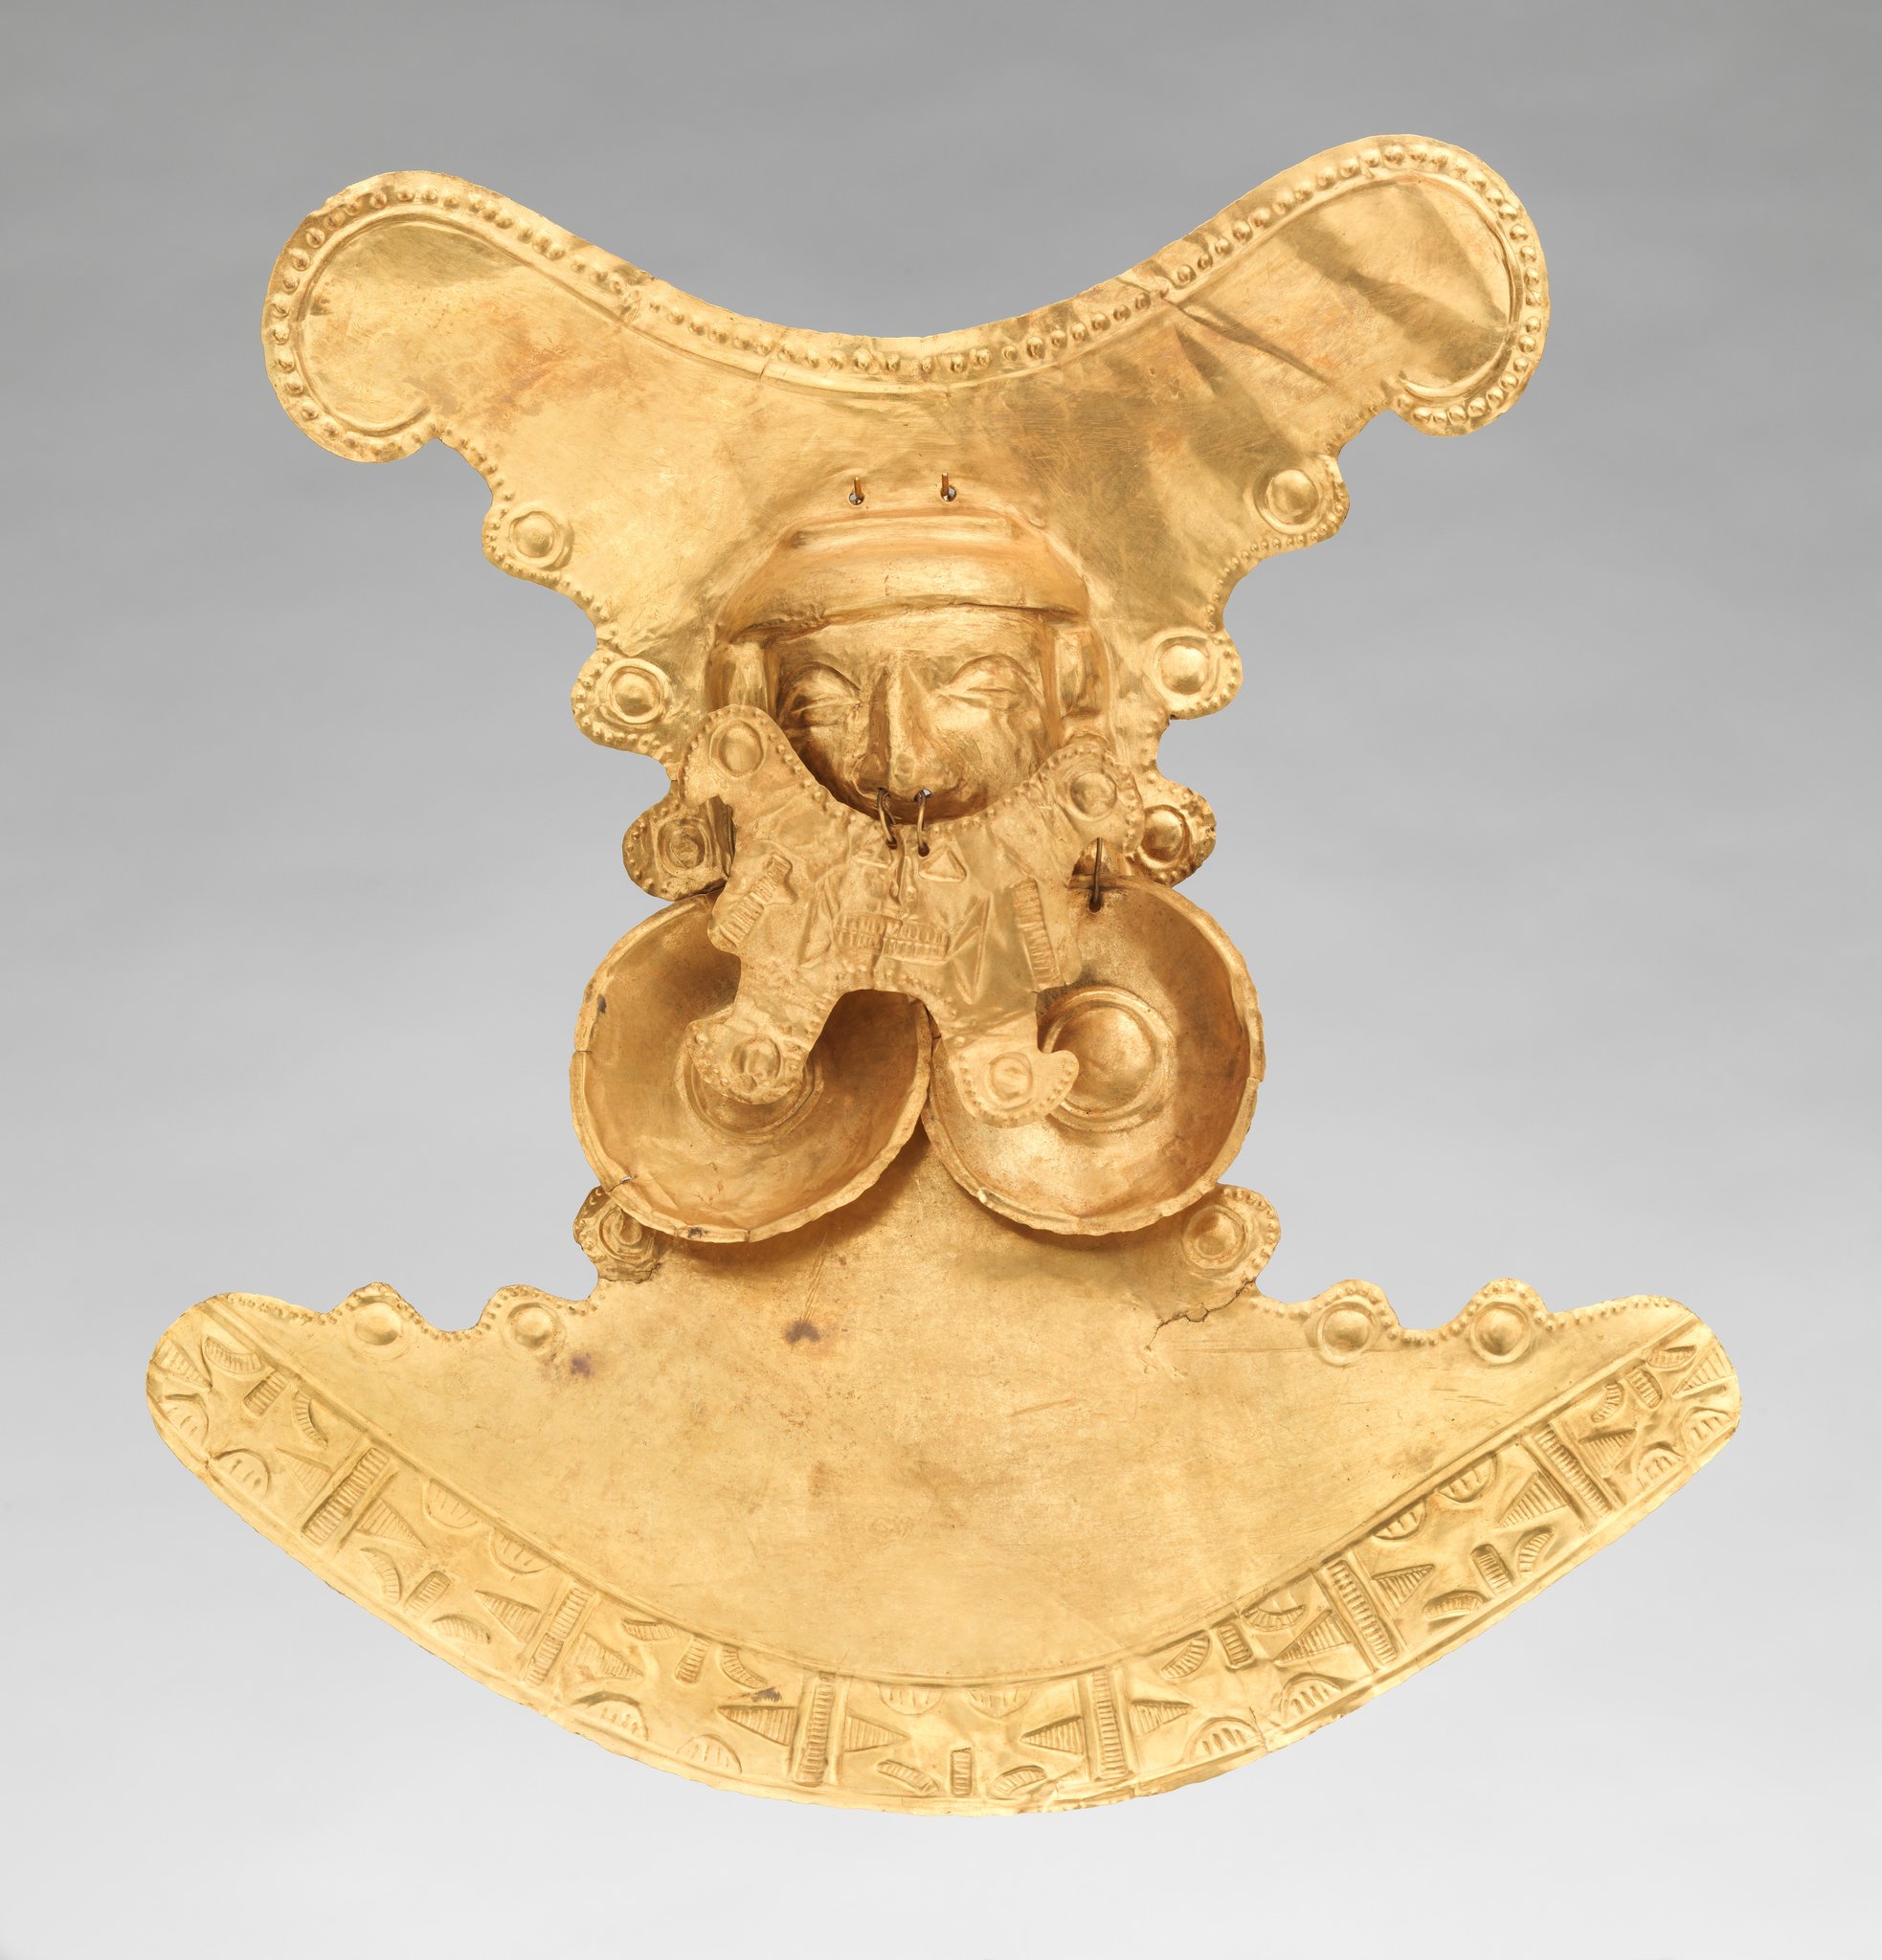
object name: pectoral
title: Pectoral with face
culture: calima or yotoco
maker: calima (yotoco) artist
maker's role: artist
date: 100 BCE-800 CE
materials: gold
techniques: hammering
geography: colombia